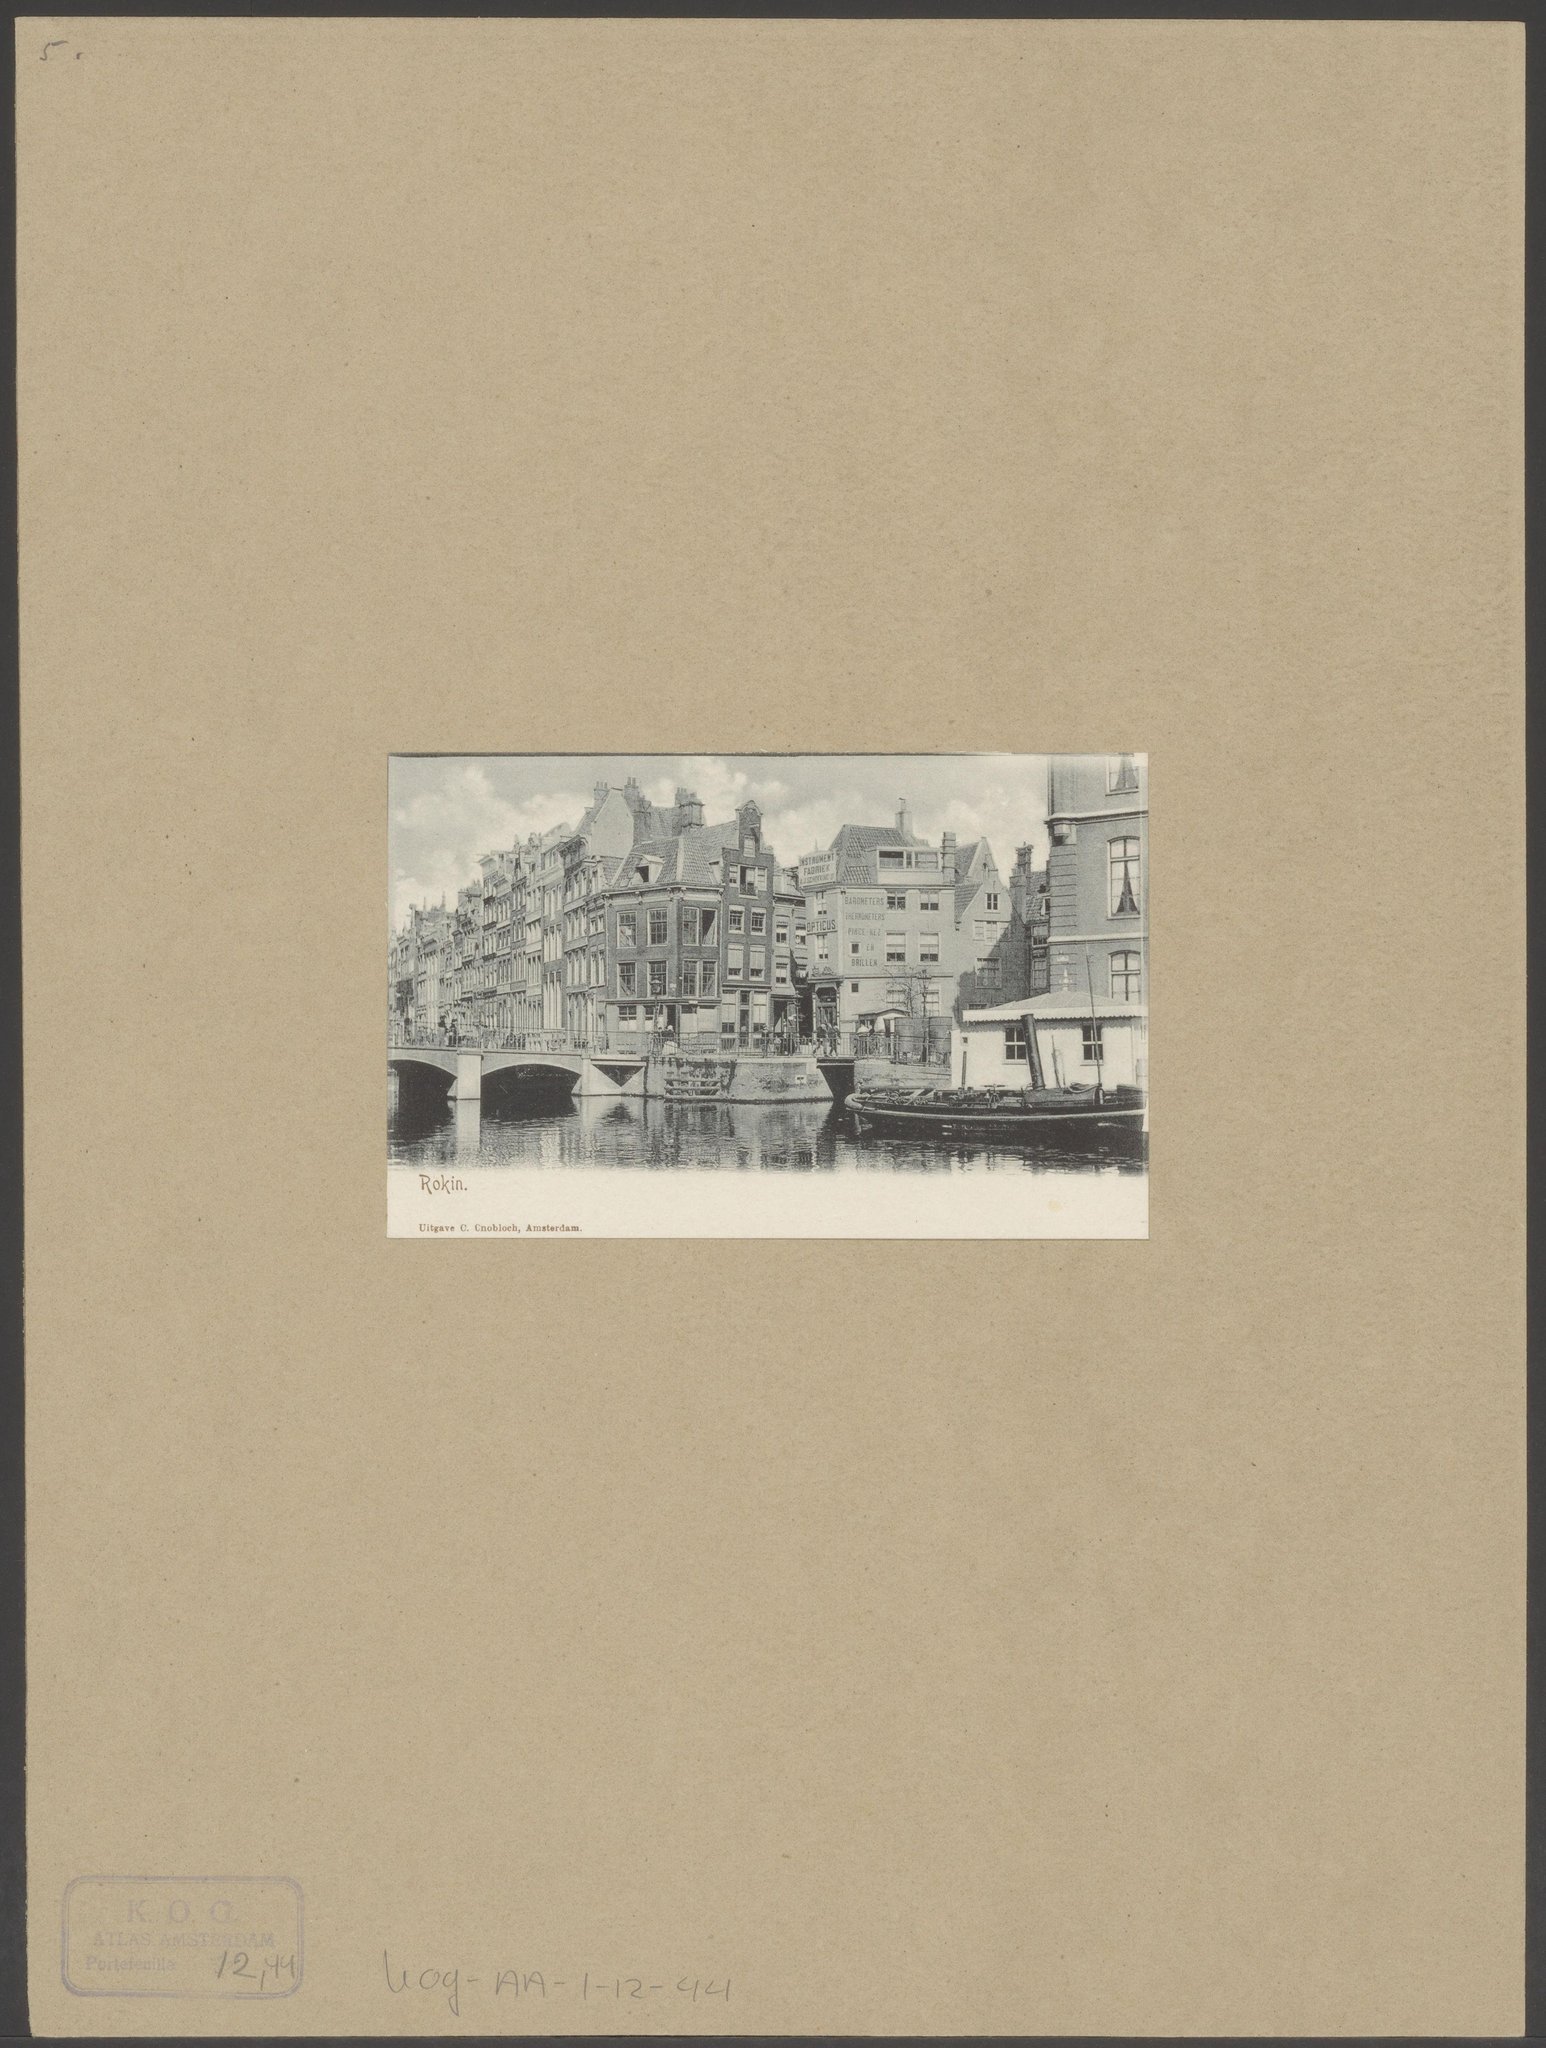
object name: photomechanical print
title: Gezicht op het Rokin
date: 1875-1905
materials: cardboard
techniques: photograph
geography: amsterdam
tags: city-view in general; 'veduta', canal, the usual house or row of houses, bridge in city across river, canal, etc.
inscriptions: collector's mark: ‘12,44’ Lugt 1641b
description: Onderwerpsrubriek binnen de Atlas Amsterdam: Rokin, Rotterdammersloot, Rozengang, Rozengracht, Rozenstraat, Rusland, Rustenburgerstraat, Ruysdaelkade, Ruysdaelstraat, Ruyterkade (de), Ruyterweg (Admiraal de).